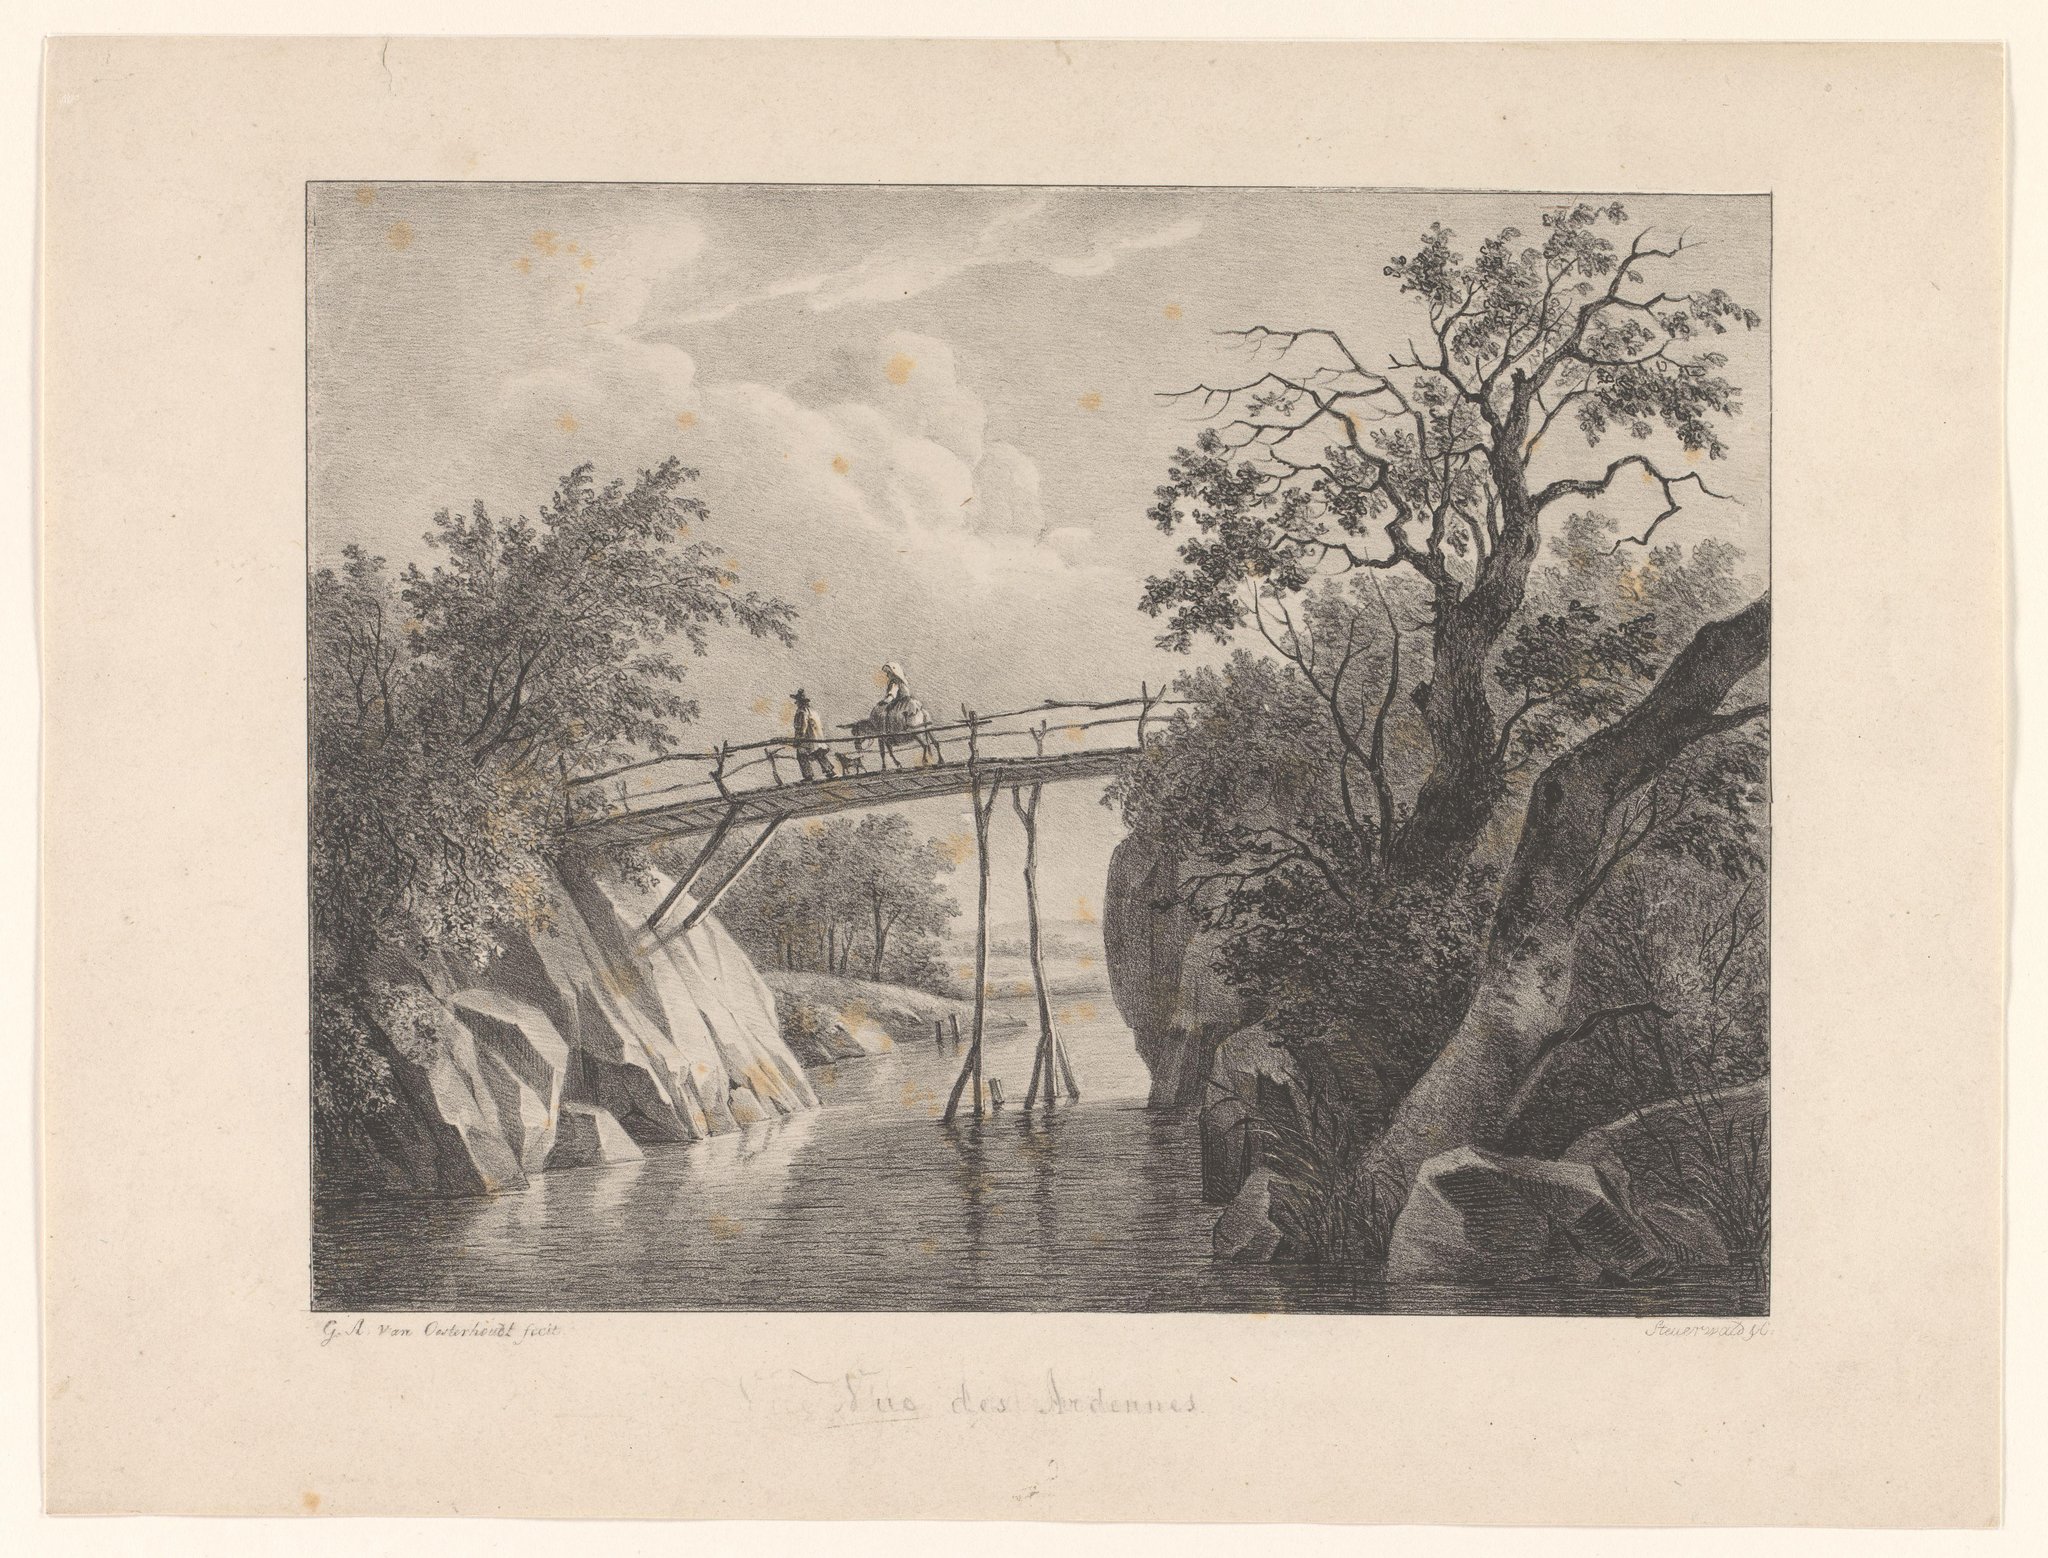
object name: print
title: Landschap in de Ardennen met figuren en ezel op een houten brug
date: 1821-1834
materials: paper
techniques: lithograph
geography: dordrecht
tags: ass, donkey, river, bridge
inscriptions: title: ‘Vue des Ardennes’